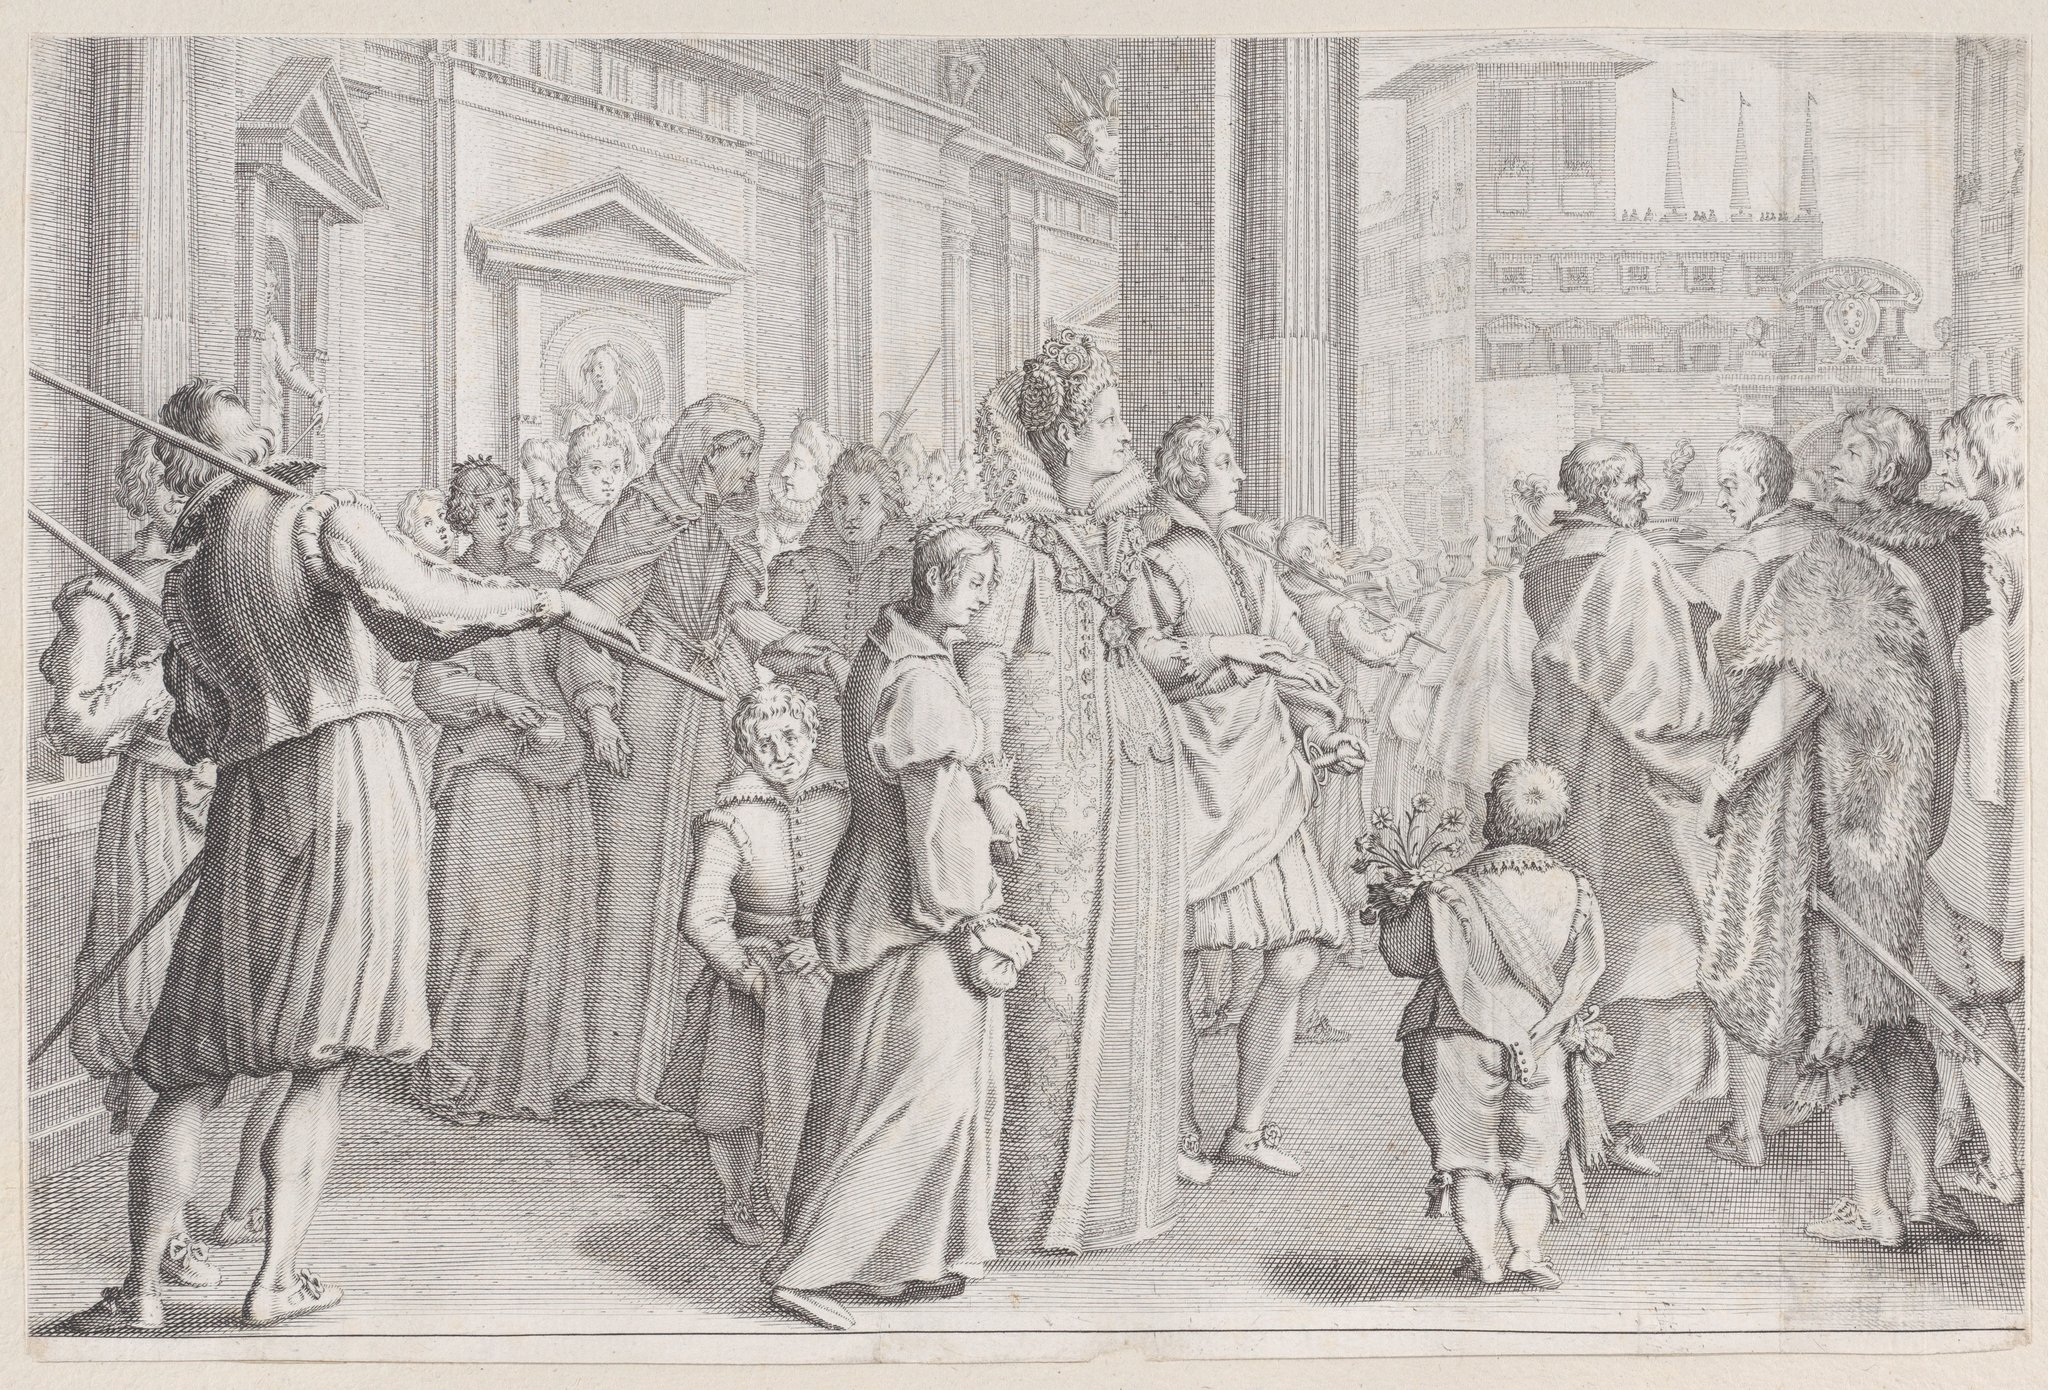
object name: print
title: La Grande Duchesse Marie des Jeunes Filles, from "La Vie de Ferdinand Ier de Médicis série appelée aussi Les Batailles des Médicis" (The Life of Ferdinand I de'Medici also called The Medici Battles)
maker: jacques callot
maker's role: artist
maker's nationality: french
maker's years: 1592-1635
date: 1614-1620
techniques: engraving